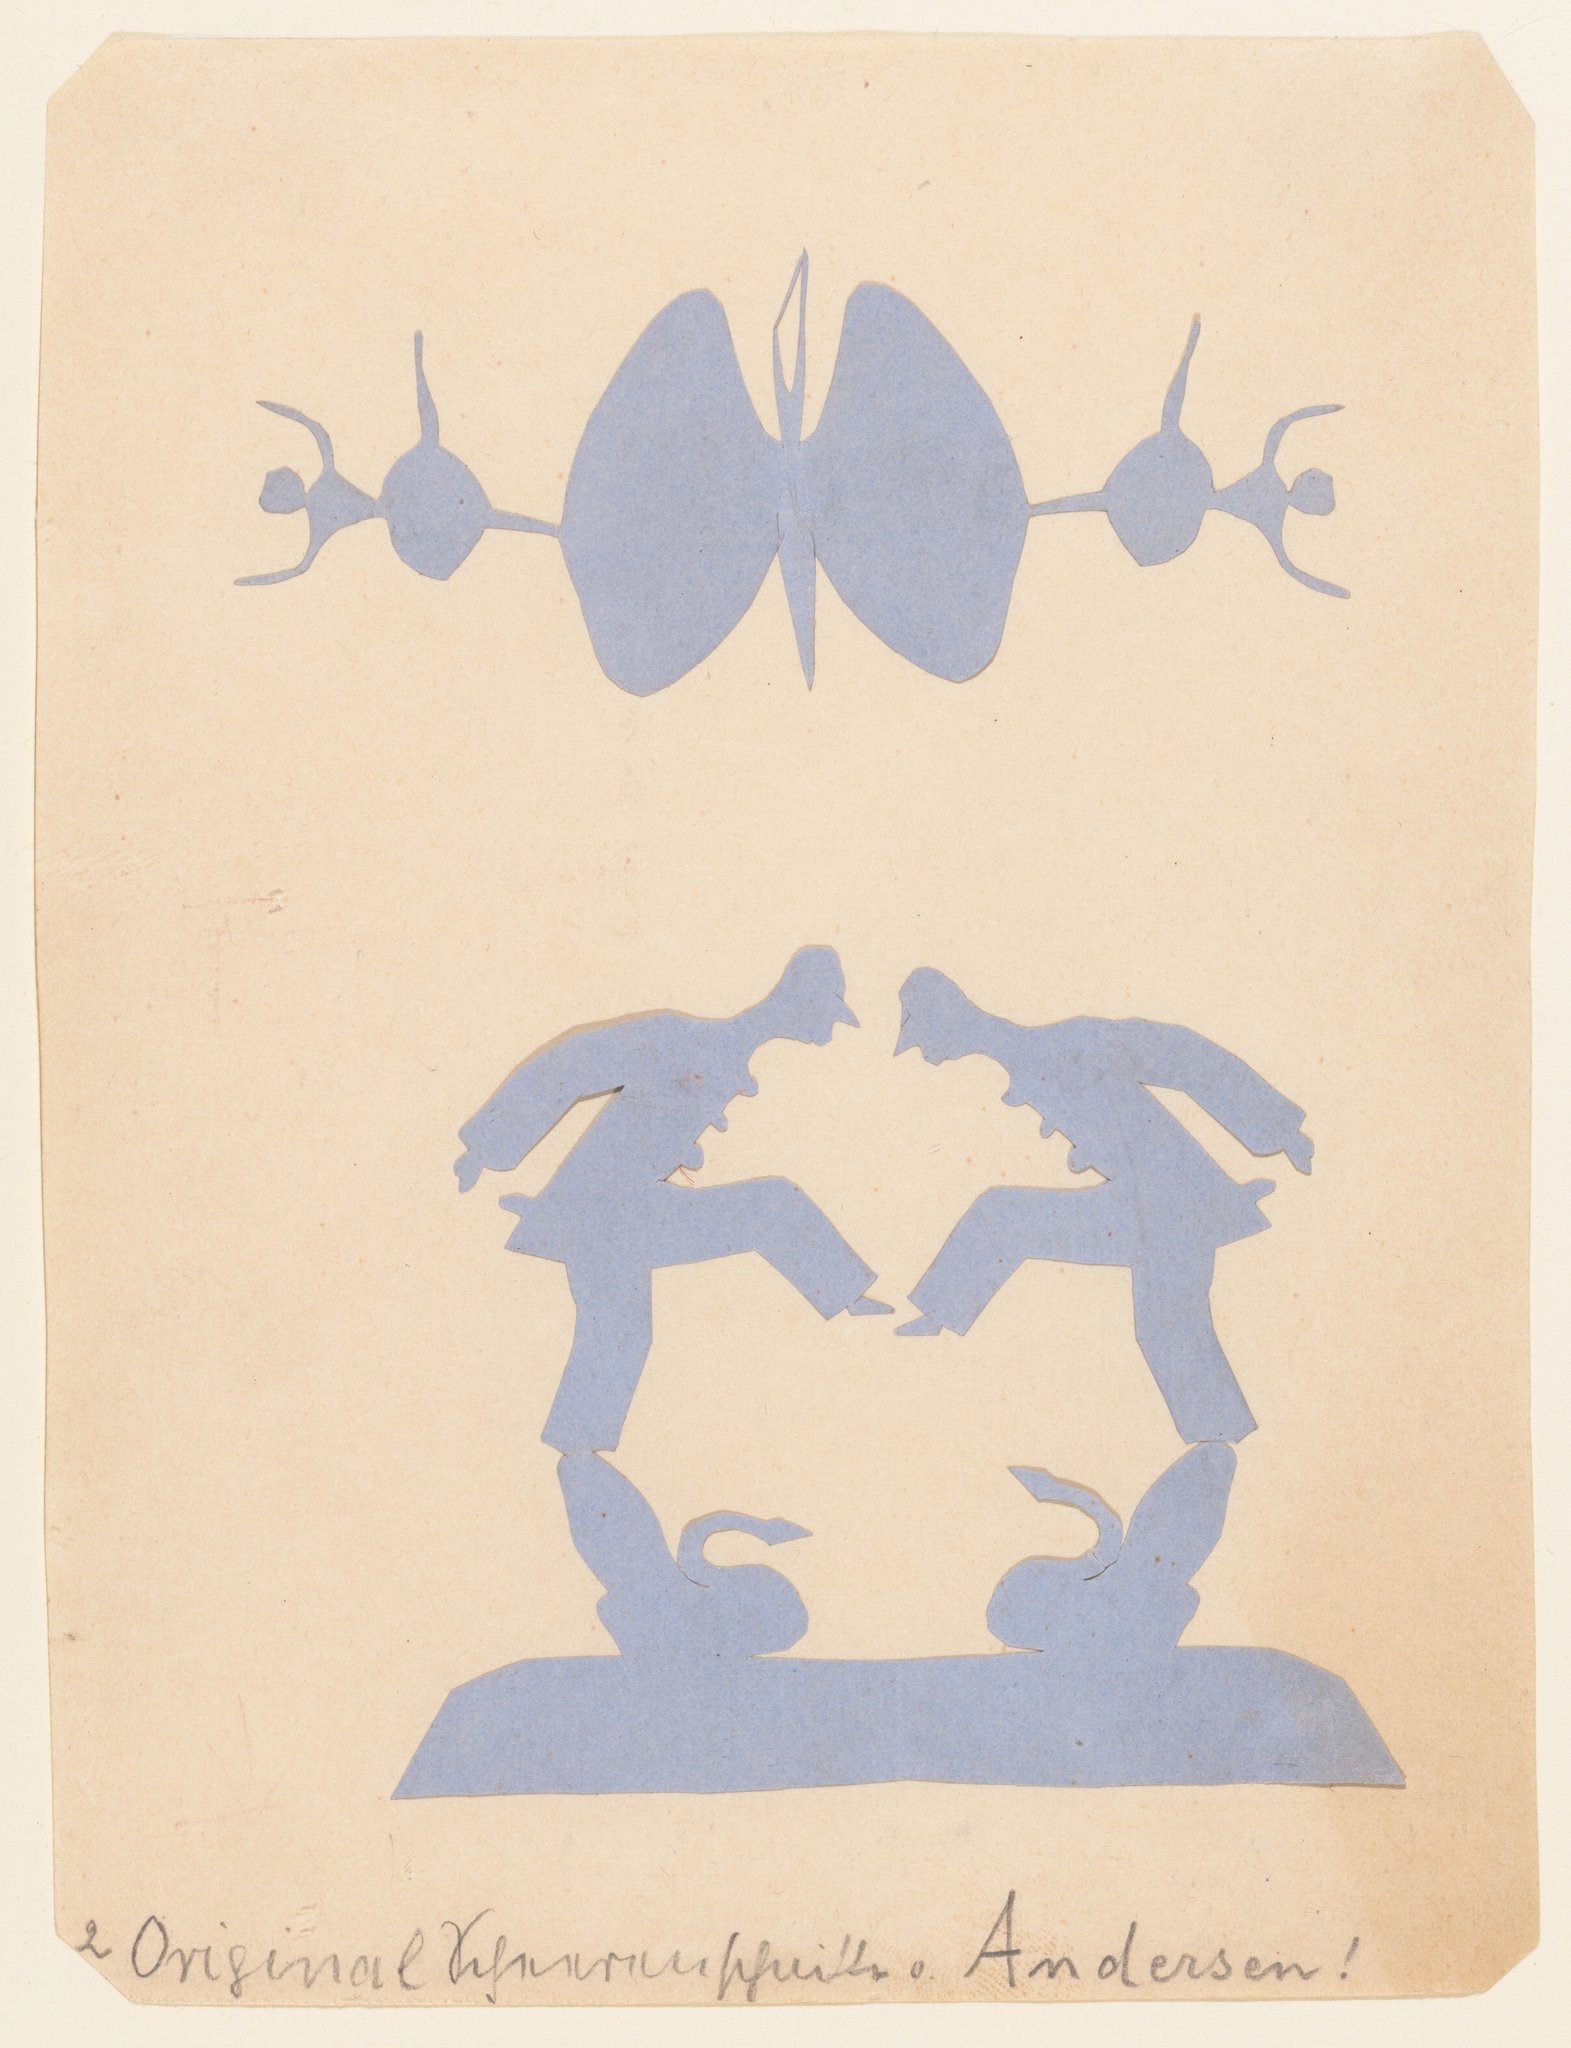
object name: cut paper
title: Two Pierrots Balancing on Swans and Two Dancers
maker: hans christian andersen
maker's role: artist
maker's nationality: danish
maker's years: 1805-1875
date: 1820-1875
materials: paper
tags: men,women,swans,dancers